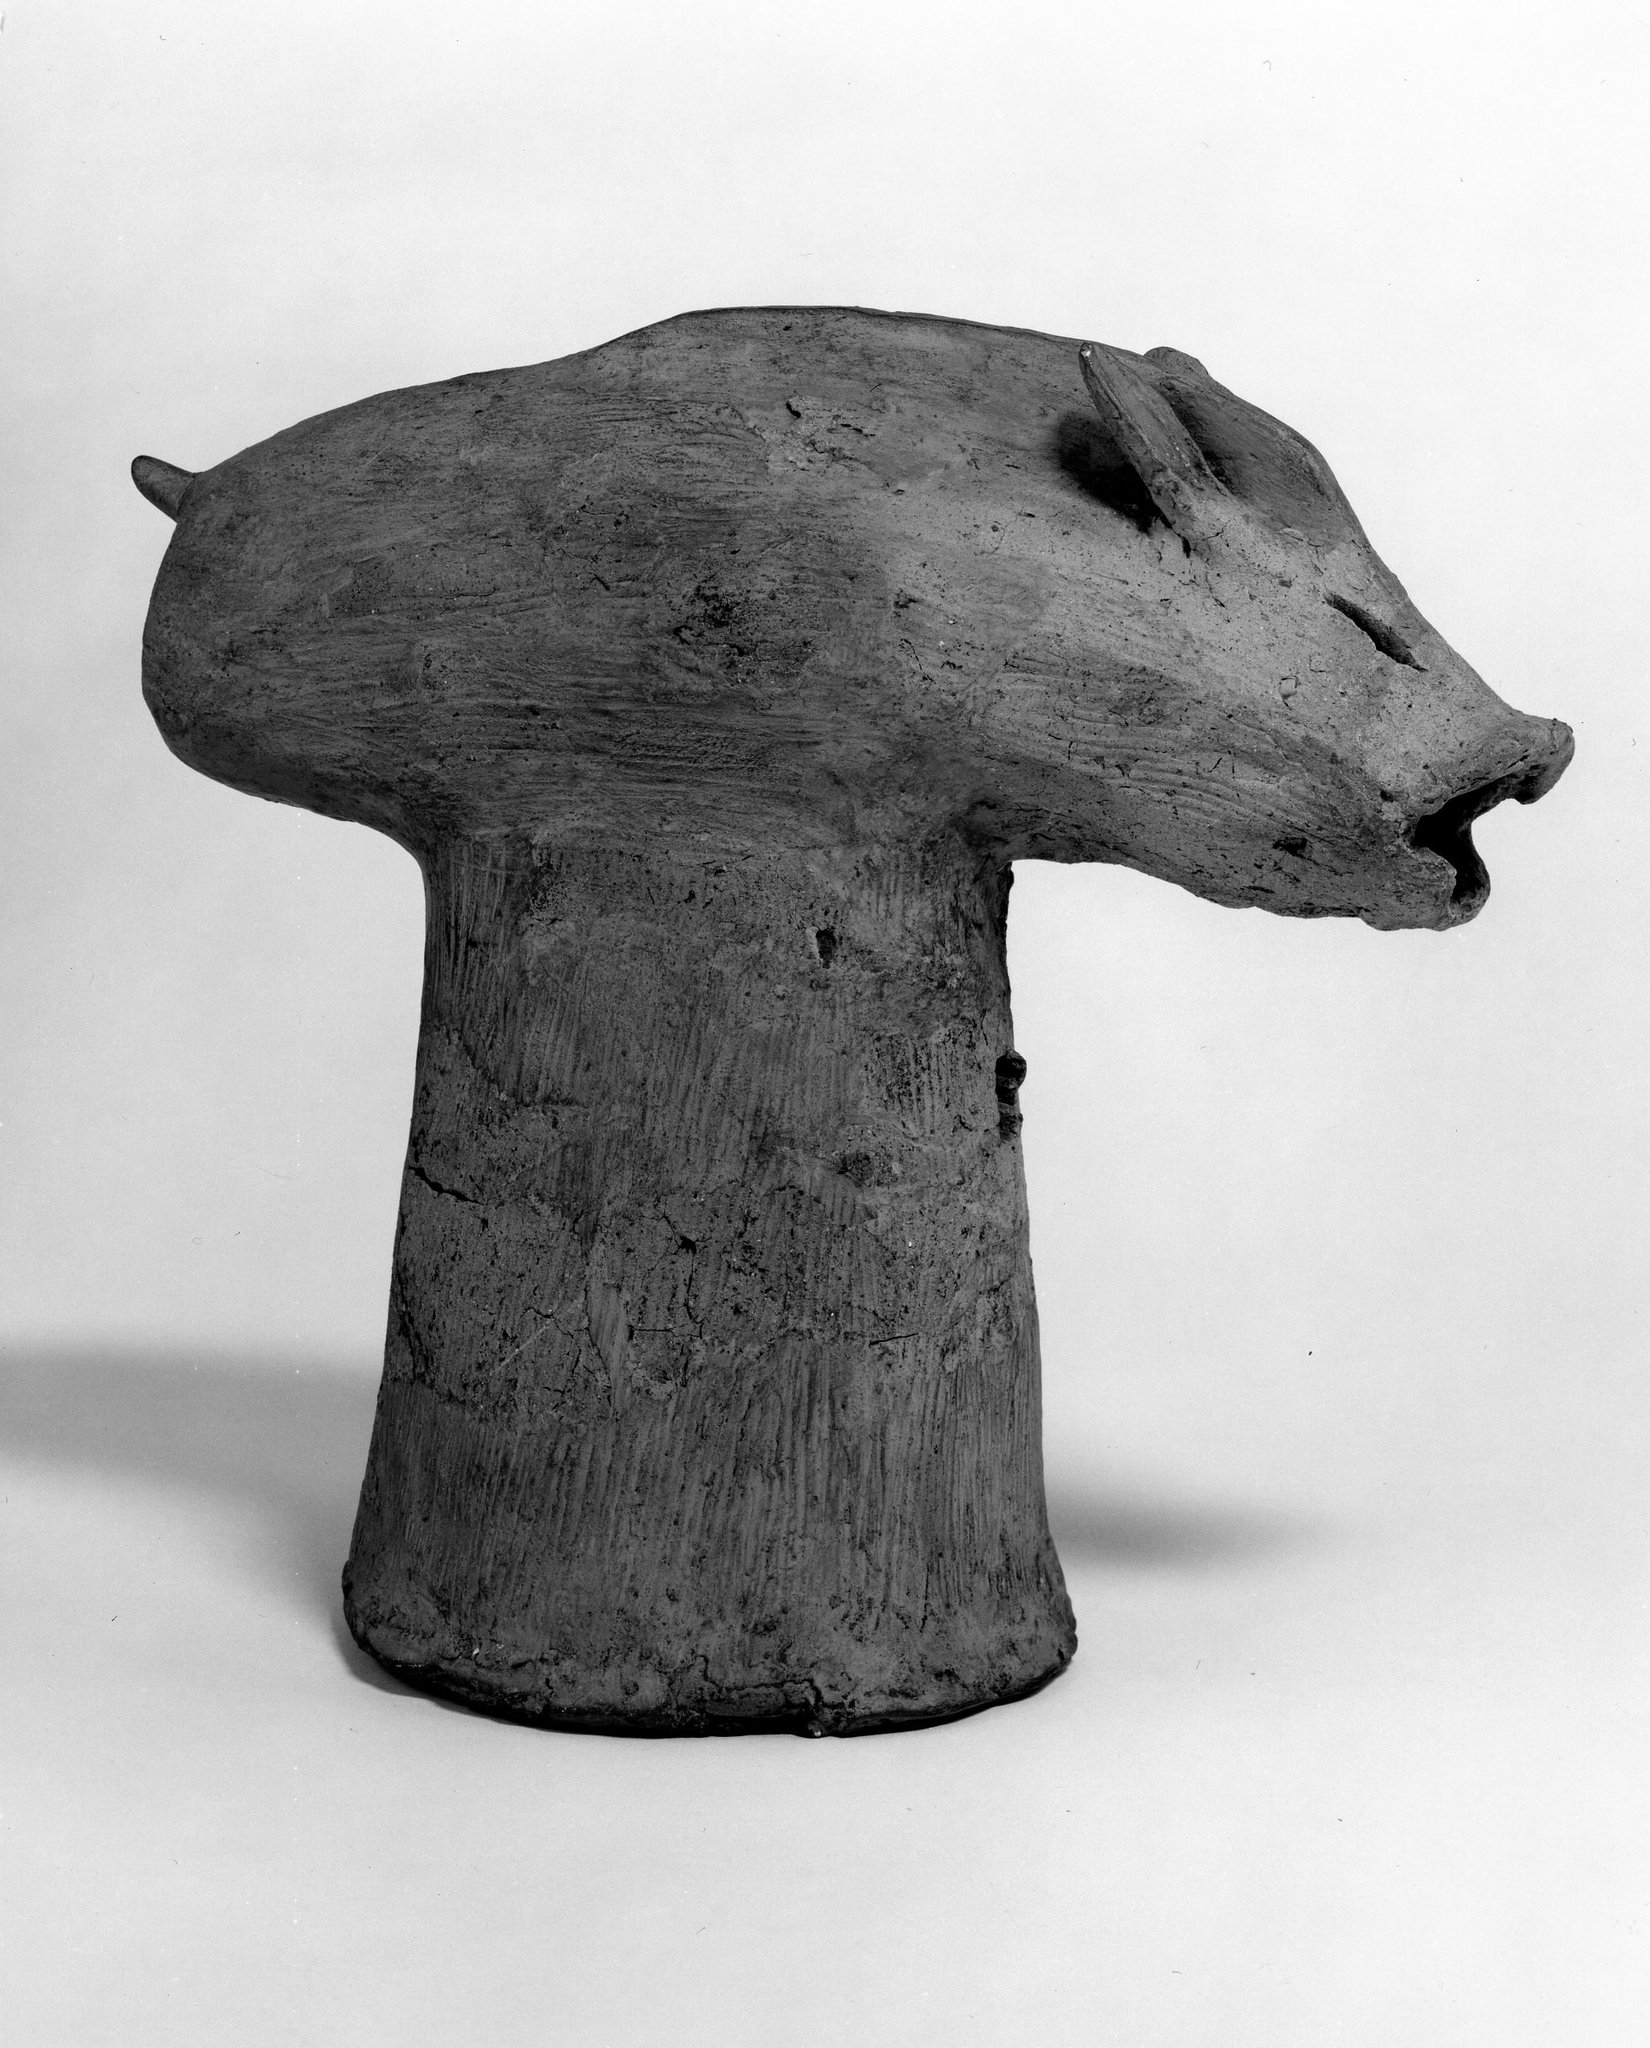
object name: haniwa head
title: Haniwa Head of Boar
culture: japanese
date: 101-300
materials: pottery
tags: boars